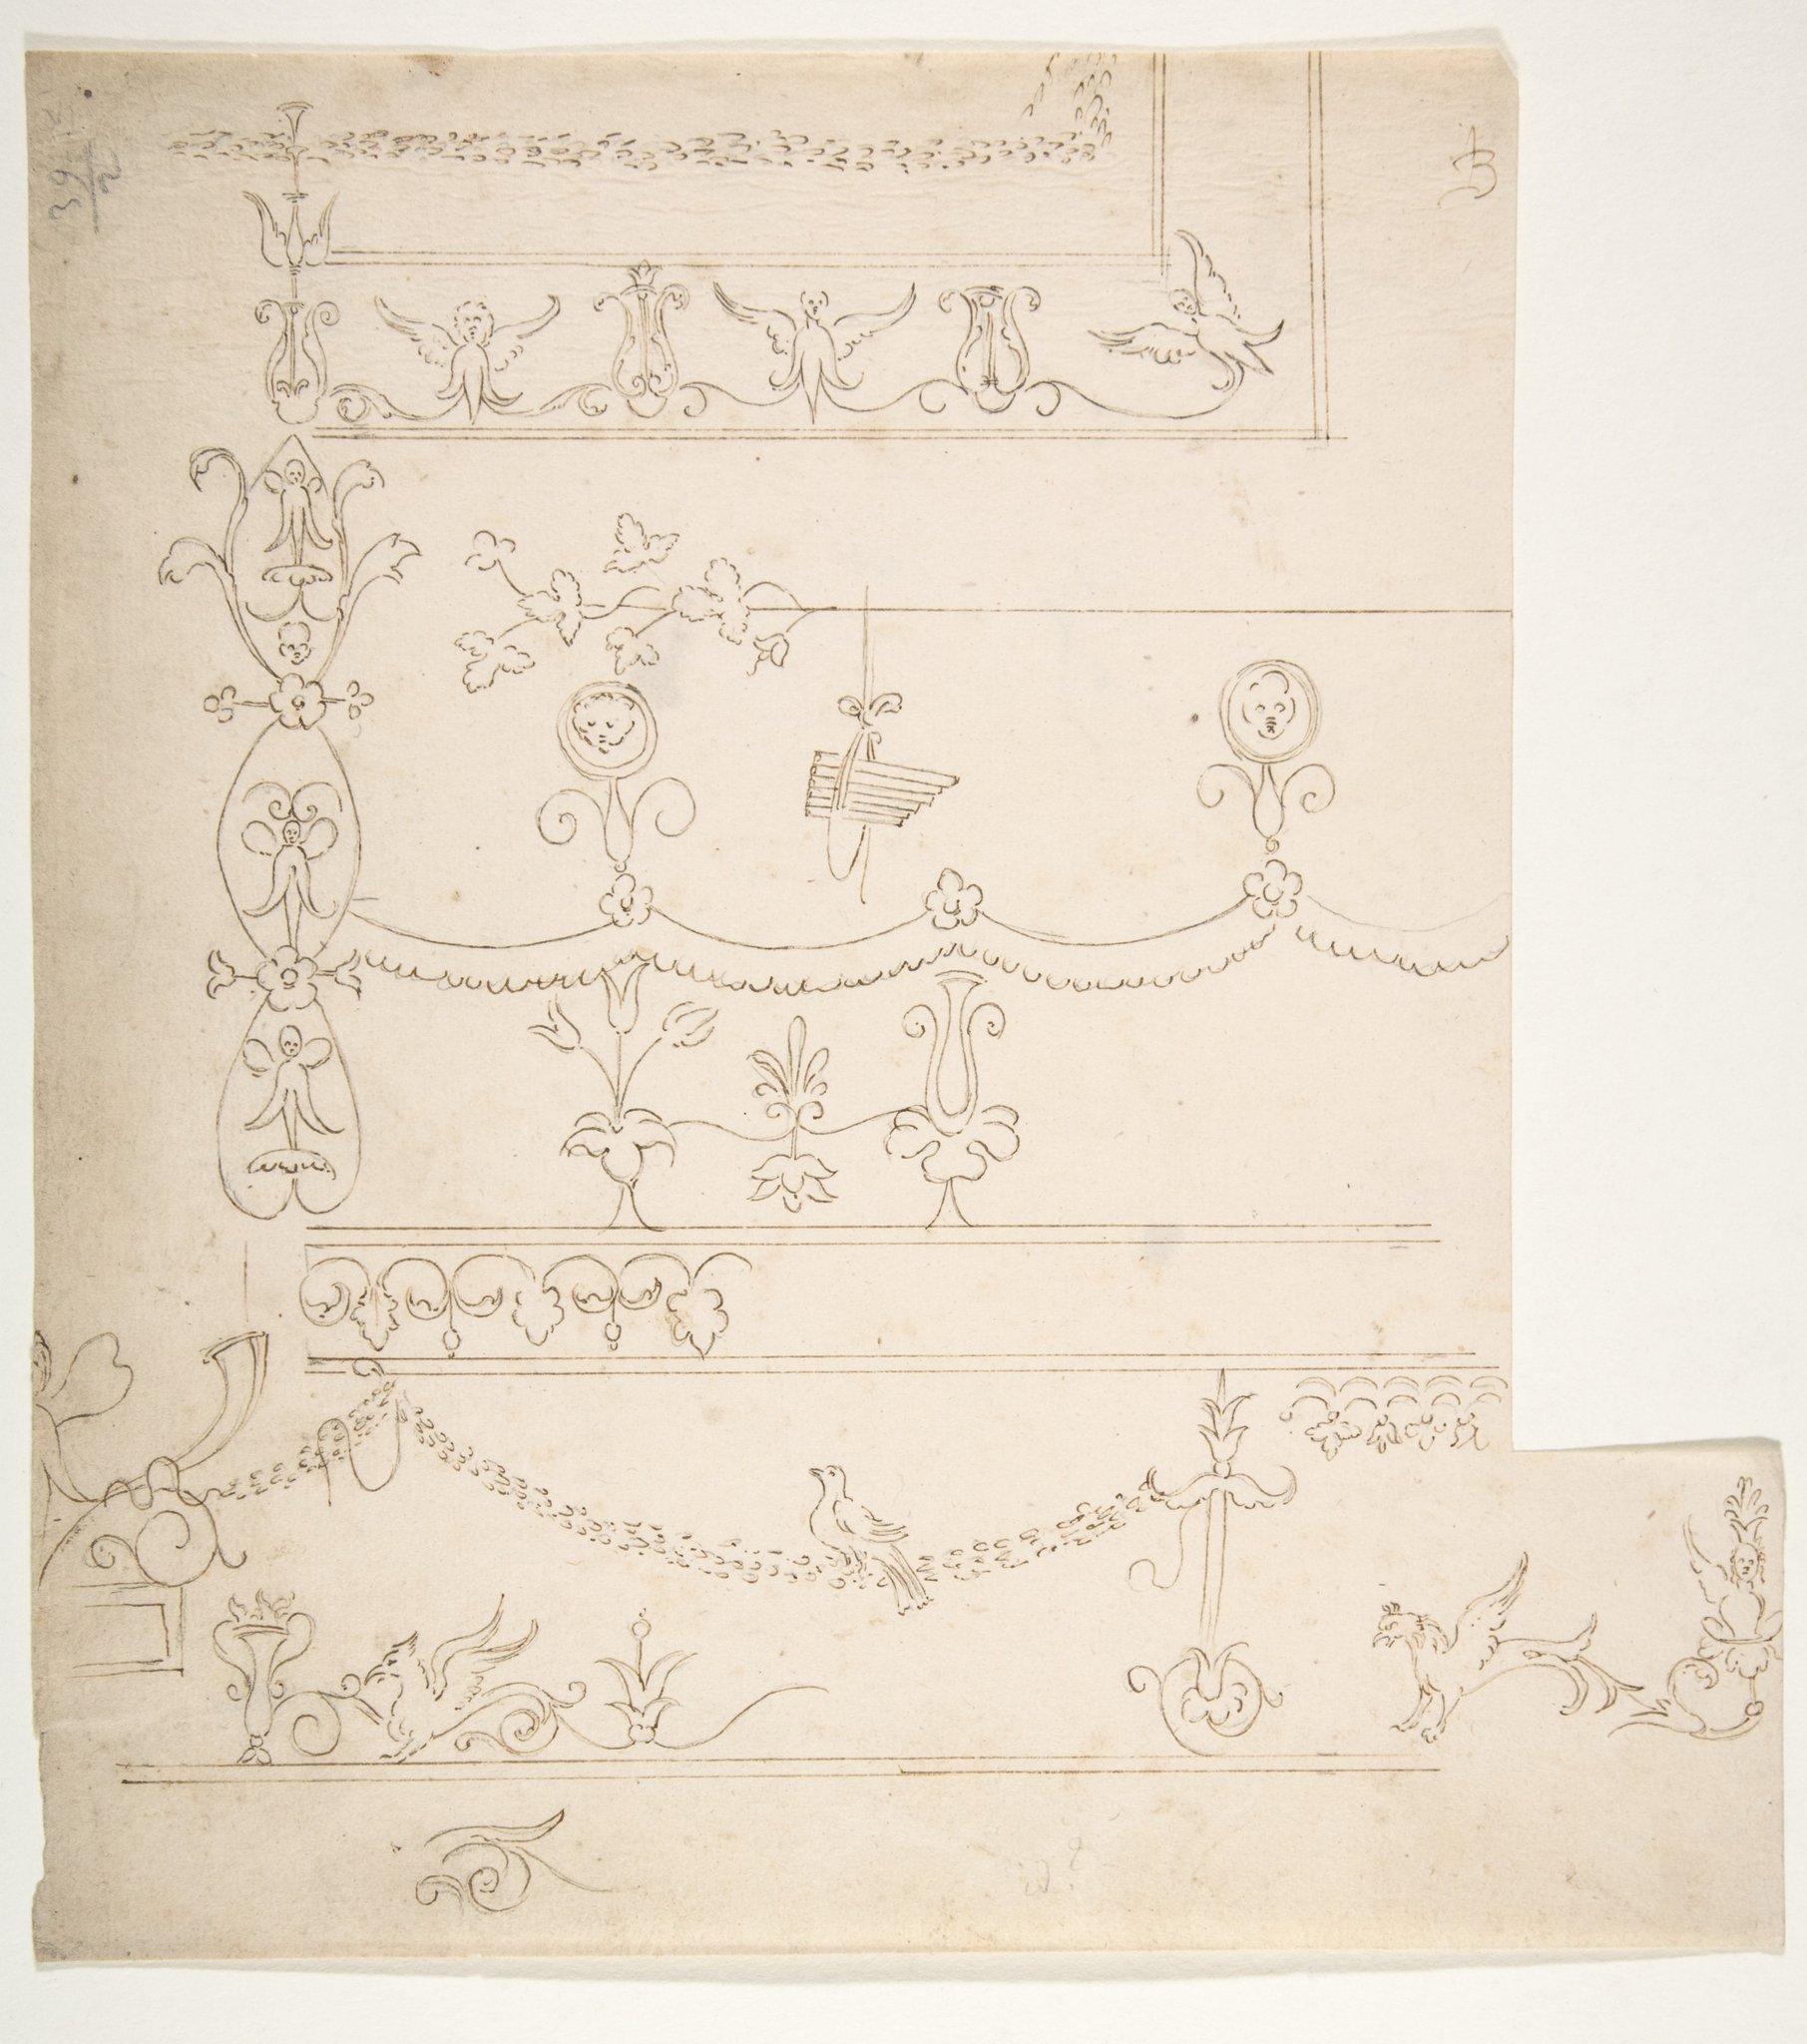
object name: collection ornament architecture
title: Domus Aurea, cryptoporticus, grostteschi, details (recto) blank (verso)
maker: anonymous, french, 16th century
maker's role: draftsman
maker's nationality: french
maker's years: 1500-1600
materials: chalk, ink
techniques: incising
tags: ornament